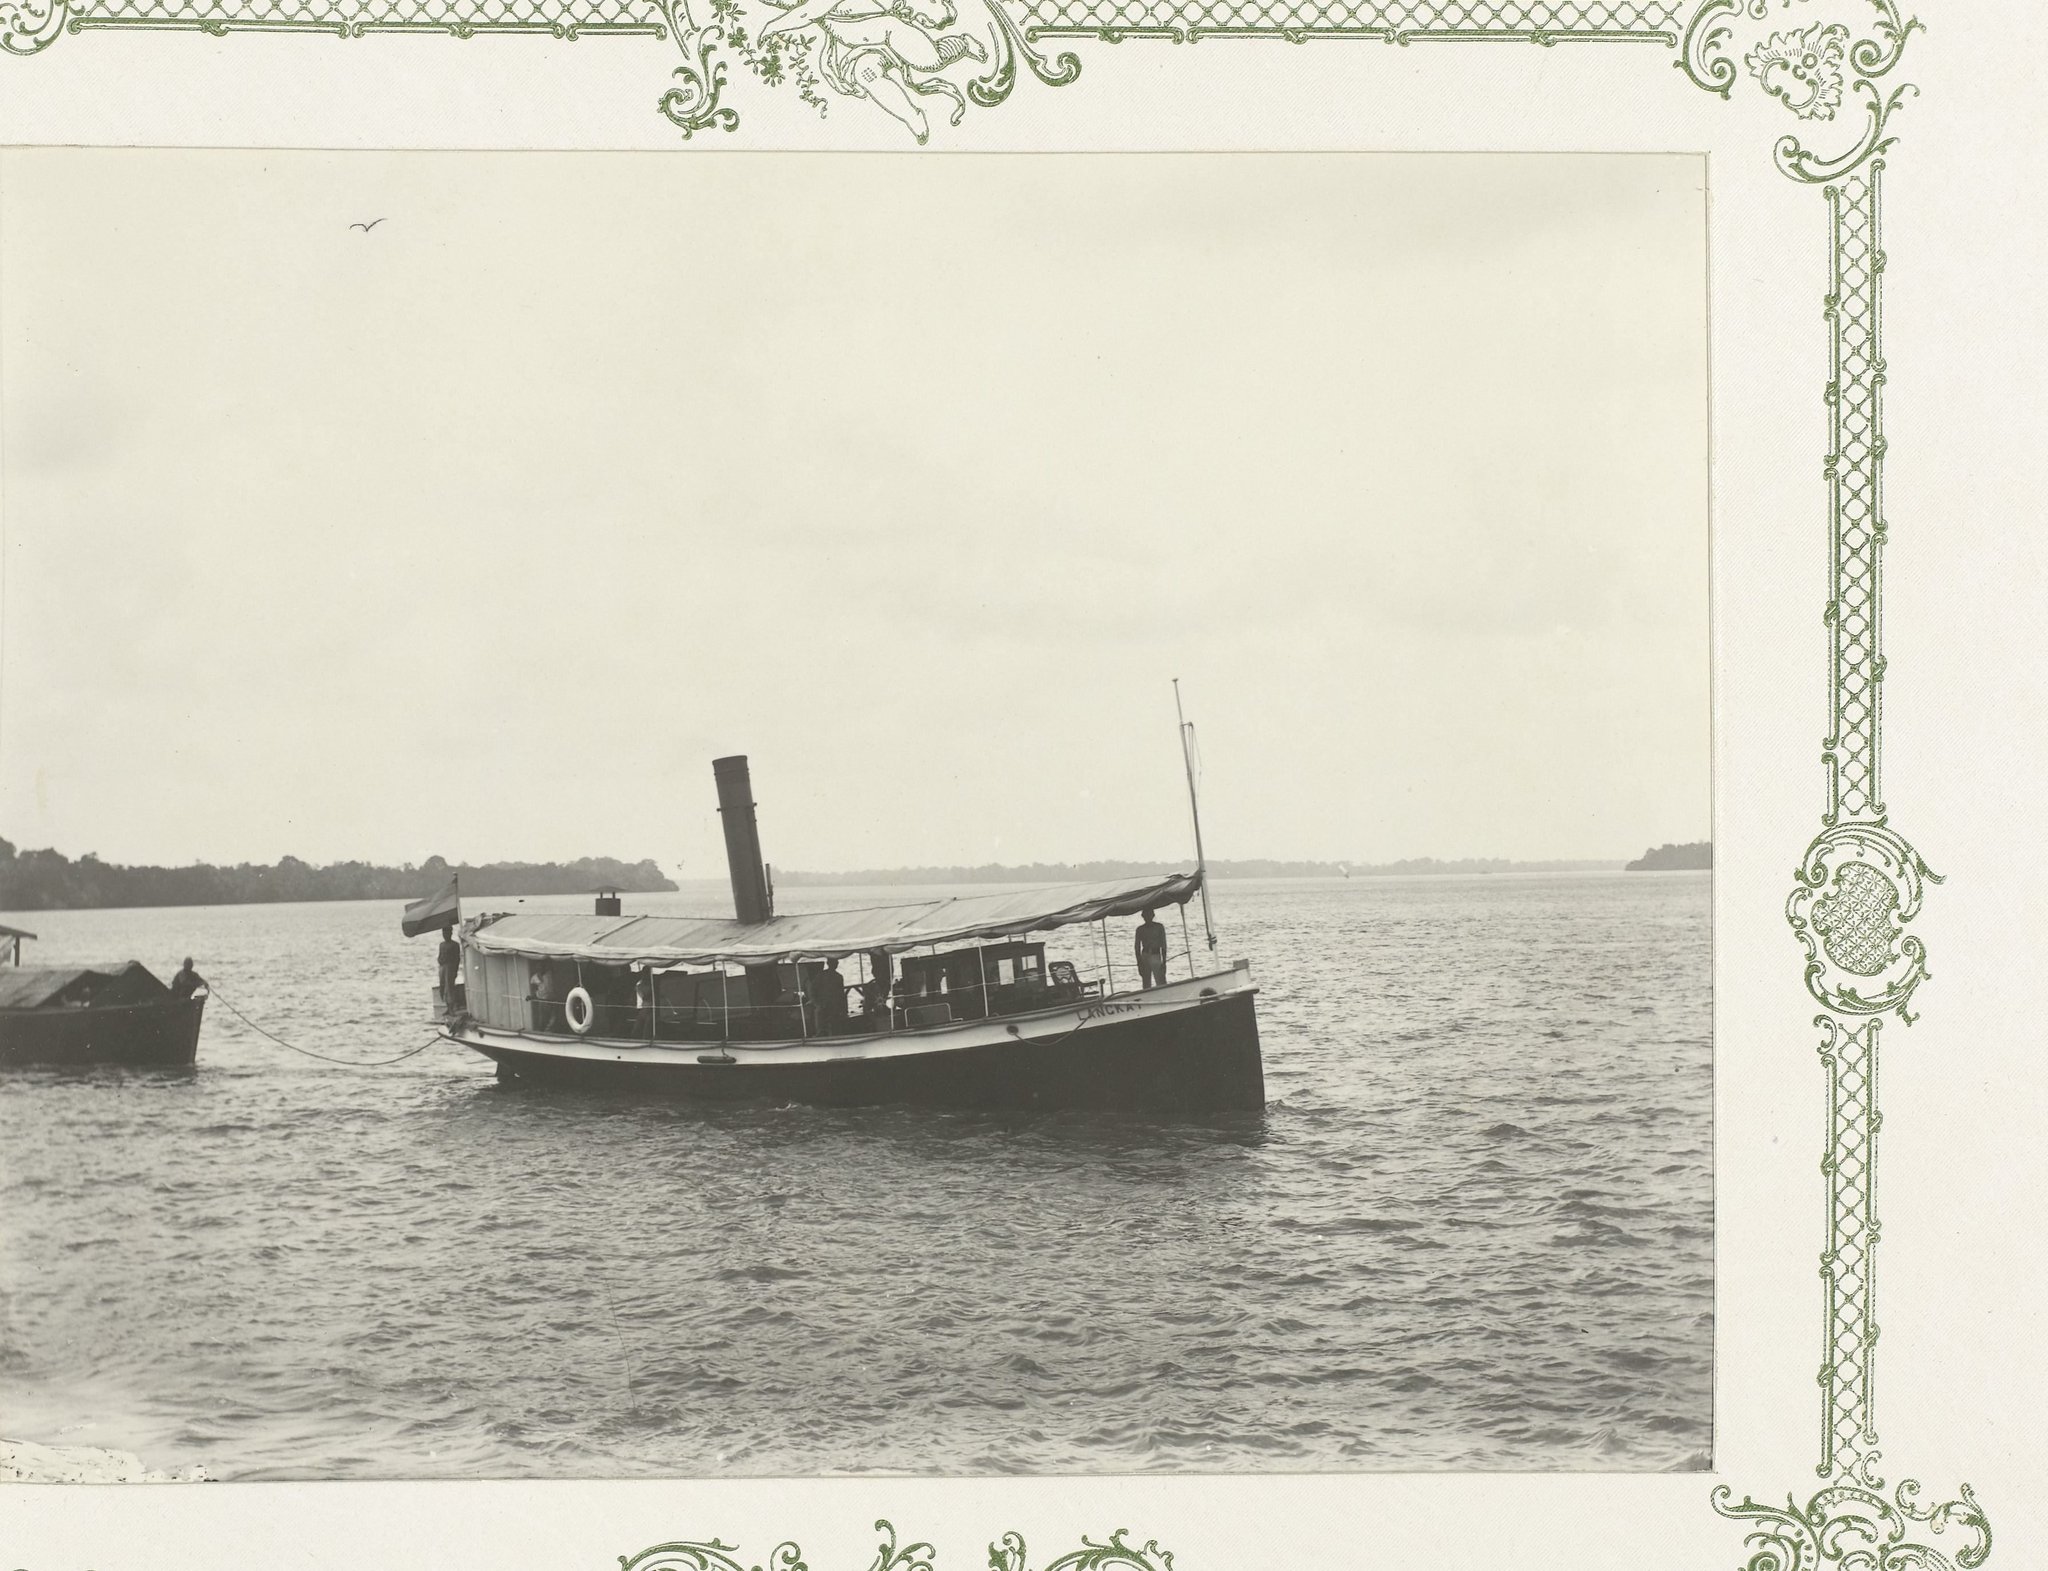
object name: album leaf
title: Boot op het water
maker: Anonymous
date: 1903-1907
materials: paper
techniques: gelatin silver print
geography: kalimantan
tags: steamship, motorship, borneo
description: Een veerboot (de Langkat) op het water te Borneo. Foto in het fotoalbum over de oliewinning op Borneo door de Koninklijke Nederlandsche Petroleum Maatschappij (KNPM) in de jaren 1903-1907.